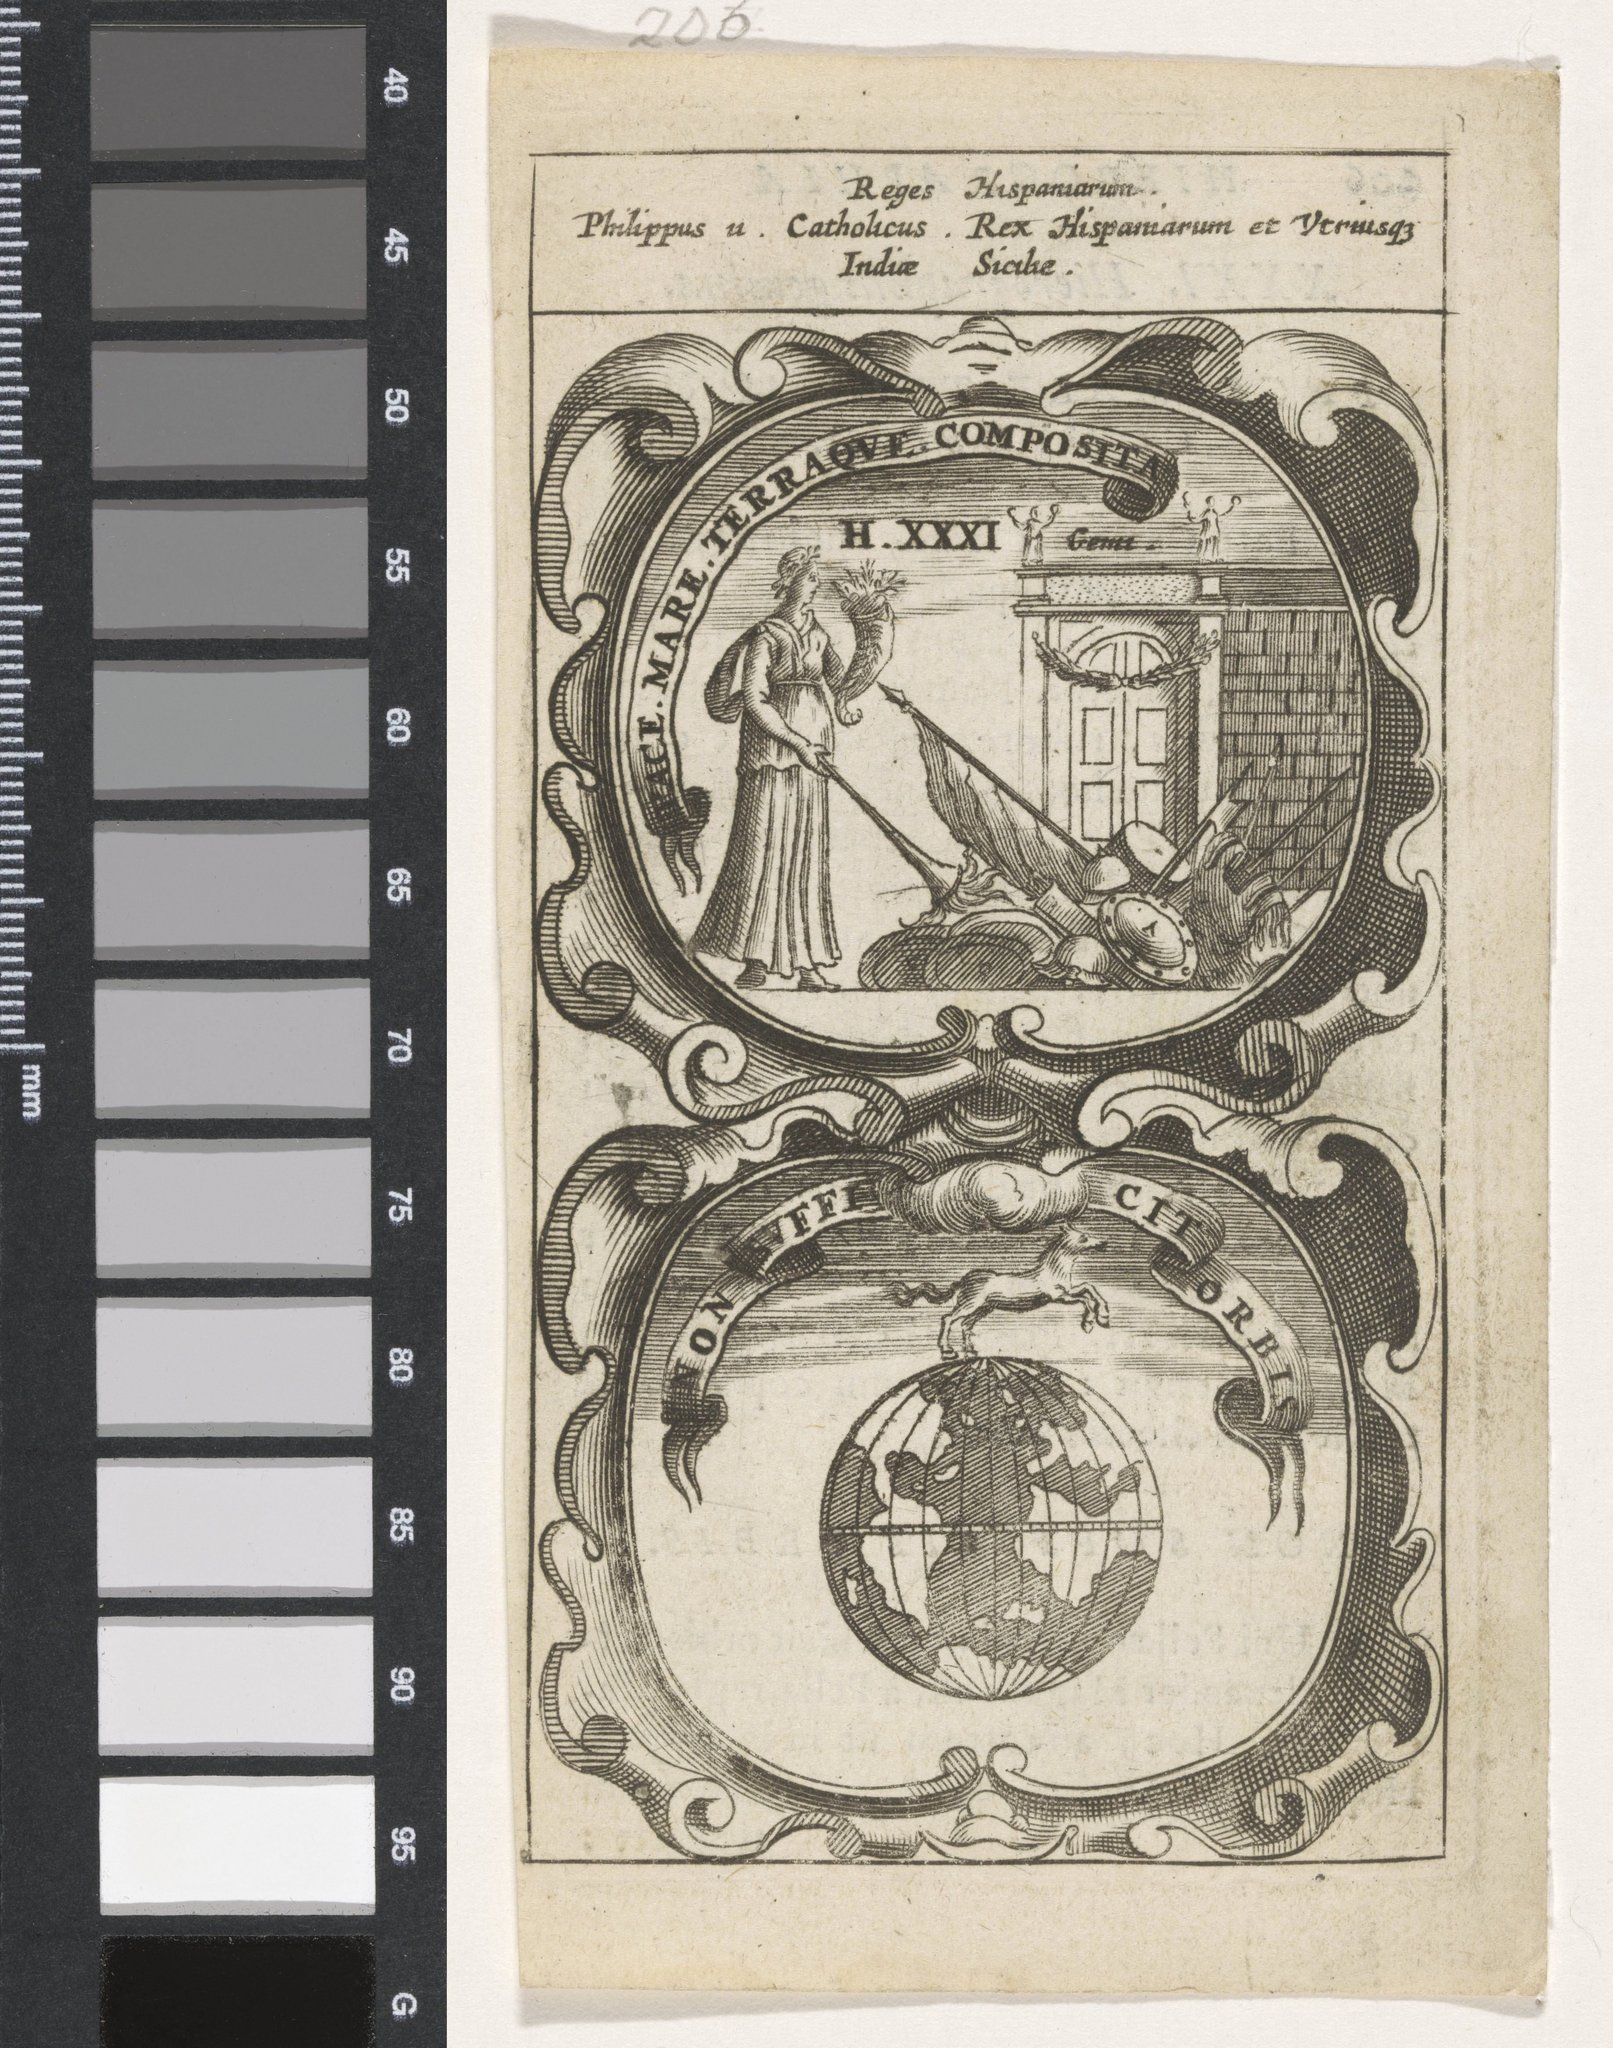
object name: print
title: Pace Mare Terraque Composita / Non Sufficit Orbis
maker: Anonymous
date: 1666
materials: paper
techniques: engraving, letterpress printing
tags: philip ii of spain, earth, world as celestial body, symbols, allegories of peace, 'pax'; 'pace' (ripa), horse, (military) equipment and supply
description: Pagina uit Jacob Typotius, Symbola Divina & Humana Pontificum Imperatorum Regum. Arnhem, J.F. Hagen, 1666 of uit de titeluitgave van 1669 of 1679. Het werk van Typotius werd voor het eerst uitgegeven in 1601 met prenten van Aegidius Sadeler.